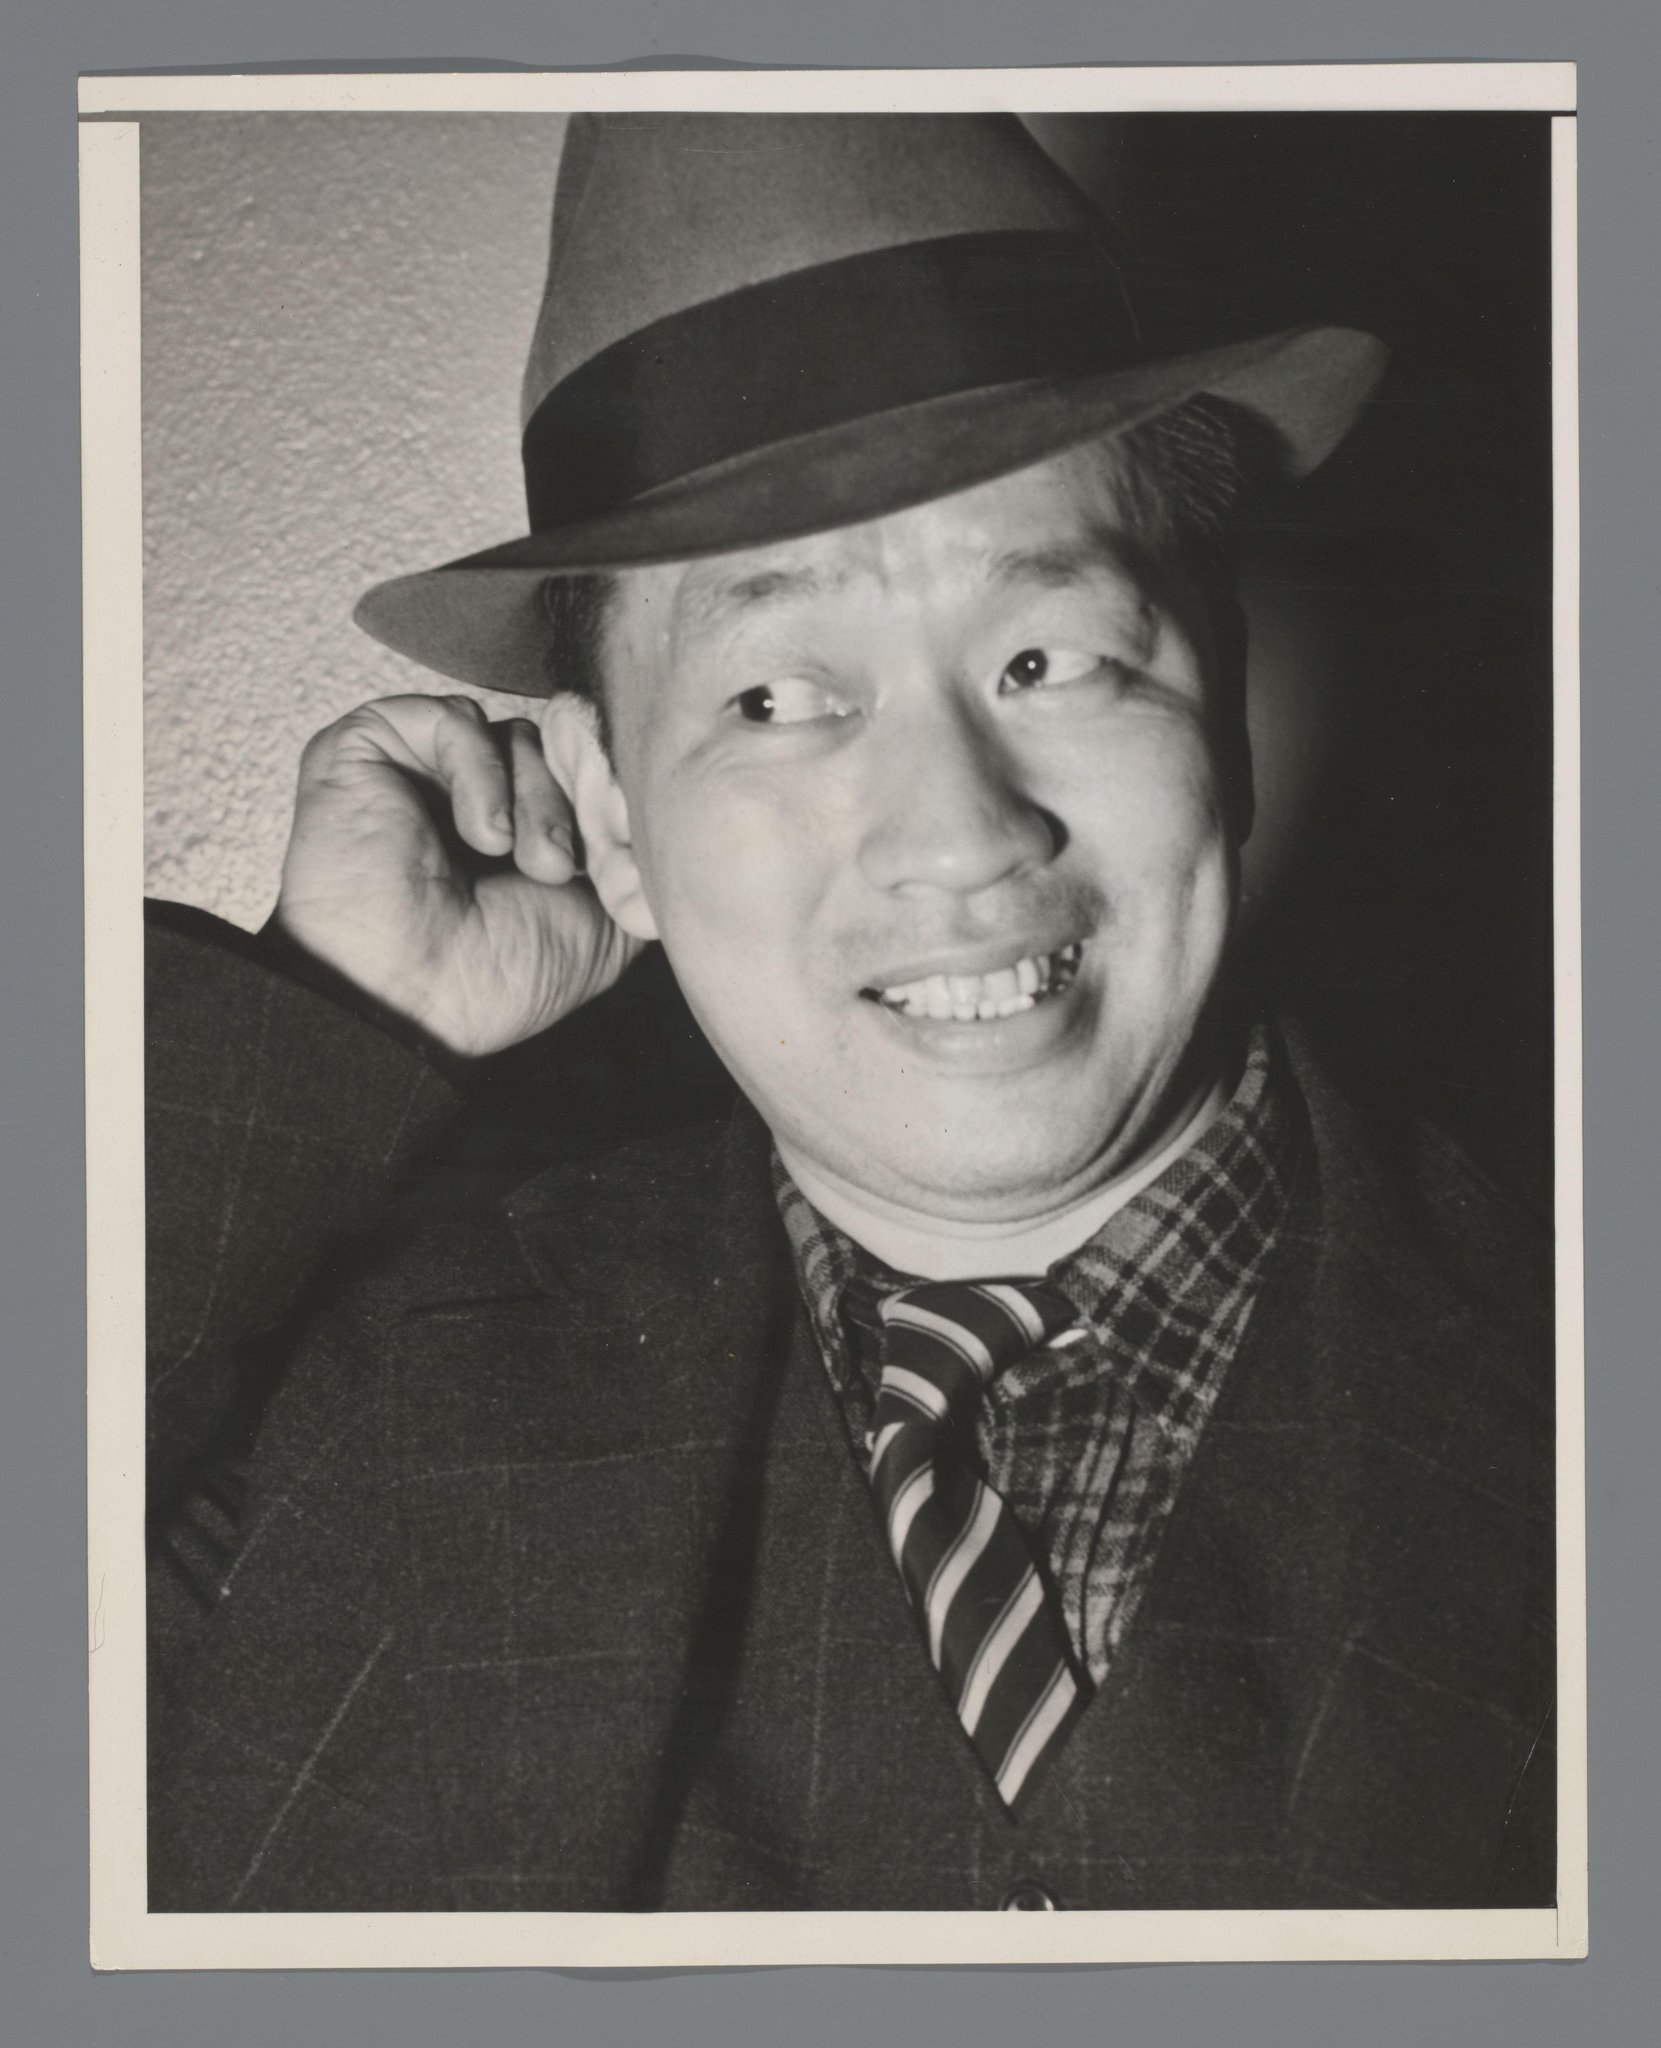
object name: photograph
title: Portret van Chung Lei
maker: Anonymous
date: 1938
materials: paper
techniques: gelatin silver print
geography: united states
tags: adult man, historical persons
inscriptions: number: ‘1751895’, inscription: ‘ACME NEWSPCTURES SANFRANCISCO BUREAU SF15759 DOPE IN EXPOSITION FIREWORKS PLOT, CHARGE SAN FRANCISCO---A bizarre story of seeking a concession at the Golden Gate International Exposition here for sale of fireworks and oriental candies---some of which would be shipped in laden with opium--was charged to Chung Lei, one-time Chinese bank president. Graduate of New York University and later a Canton bank head. Chung was ruined by the present Sino-Chinese war. A woman associate was arrested when a quantity of opium was found hidden in a false trunk bottem when she arrived by steamer. Search for Chung resulted in his indictment by a federal grand jury. (NY CHI CLEVE LA SF PRT SEAT) I-25-39’, inscription: ‘REF. DEPT./ 1-31'39/ N.E.A.’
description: Voormalig bankdirecteur Chung Lei werd gearresteerd op verdenking van opiumsmokkel.